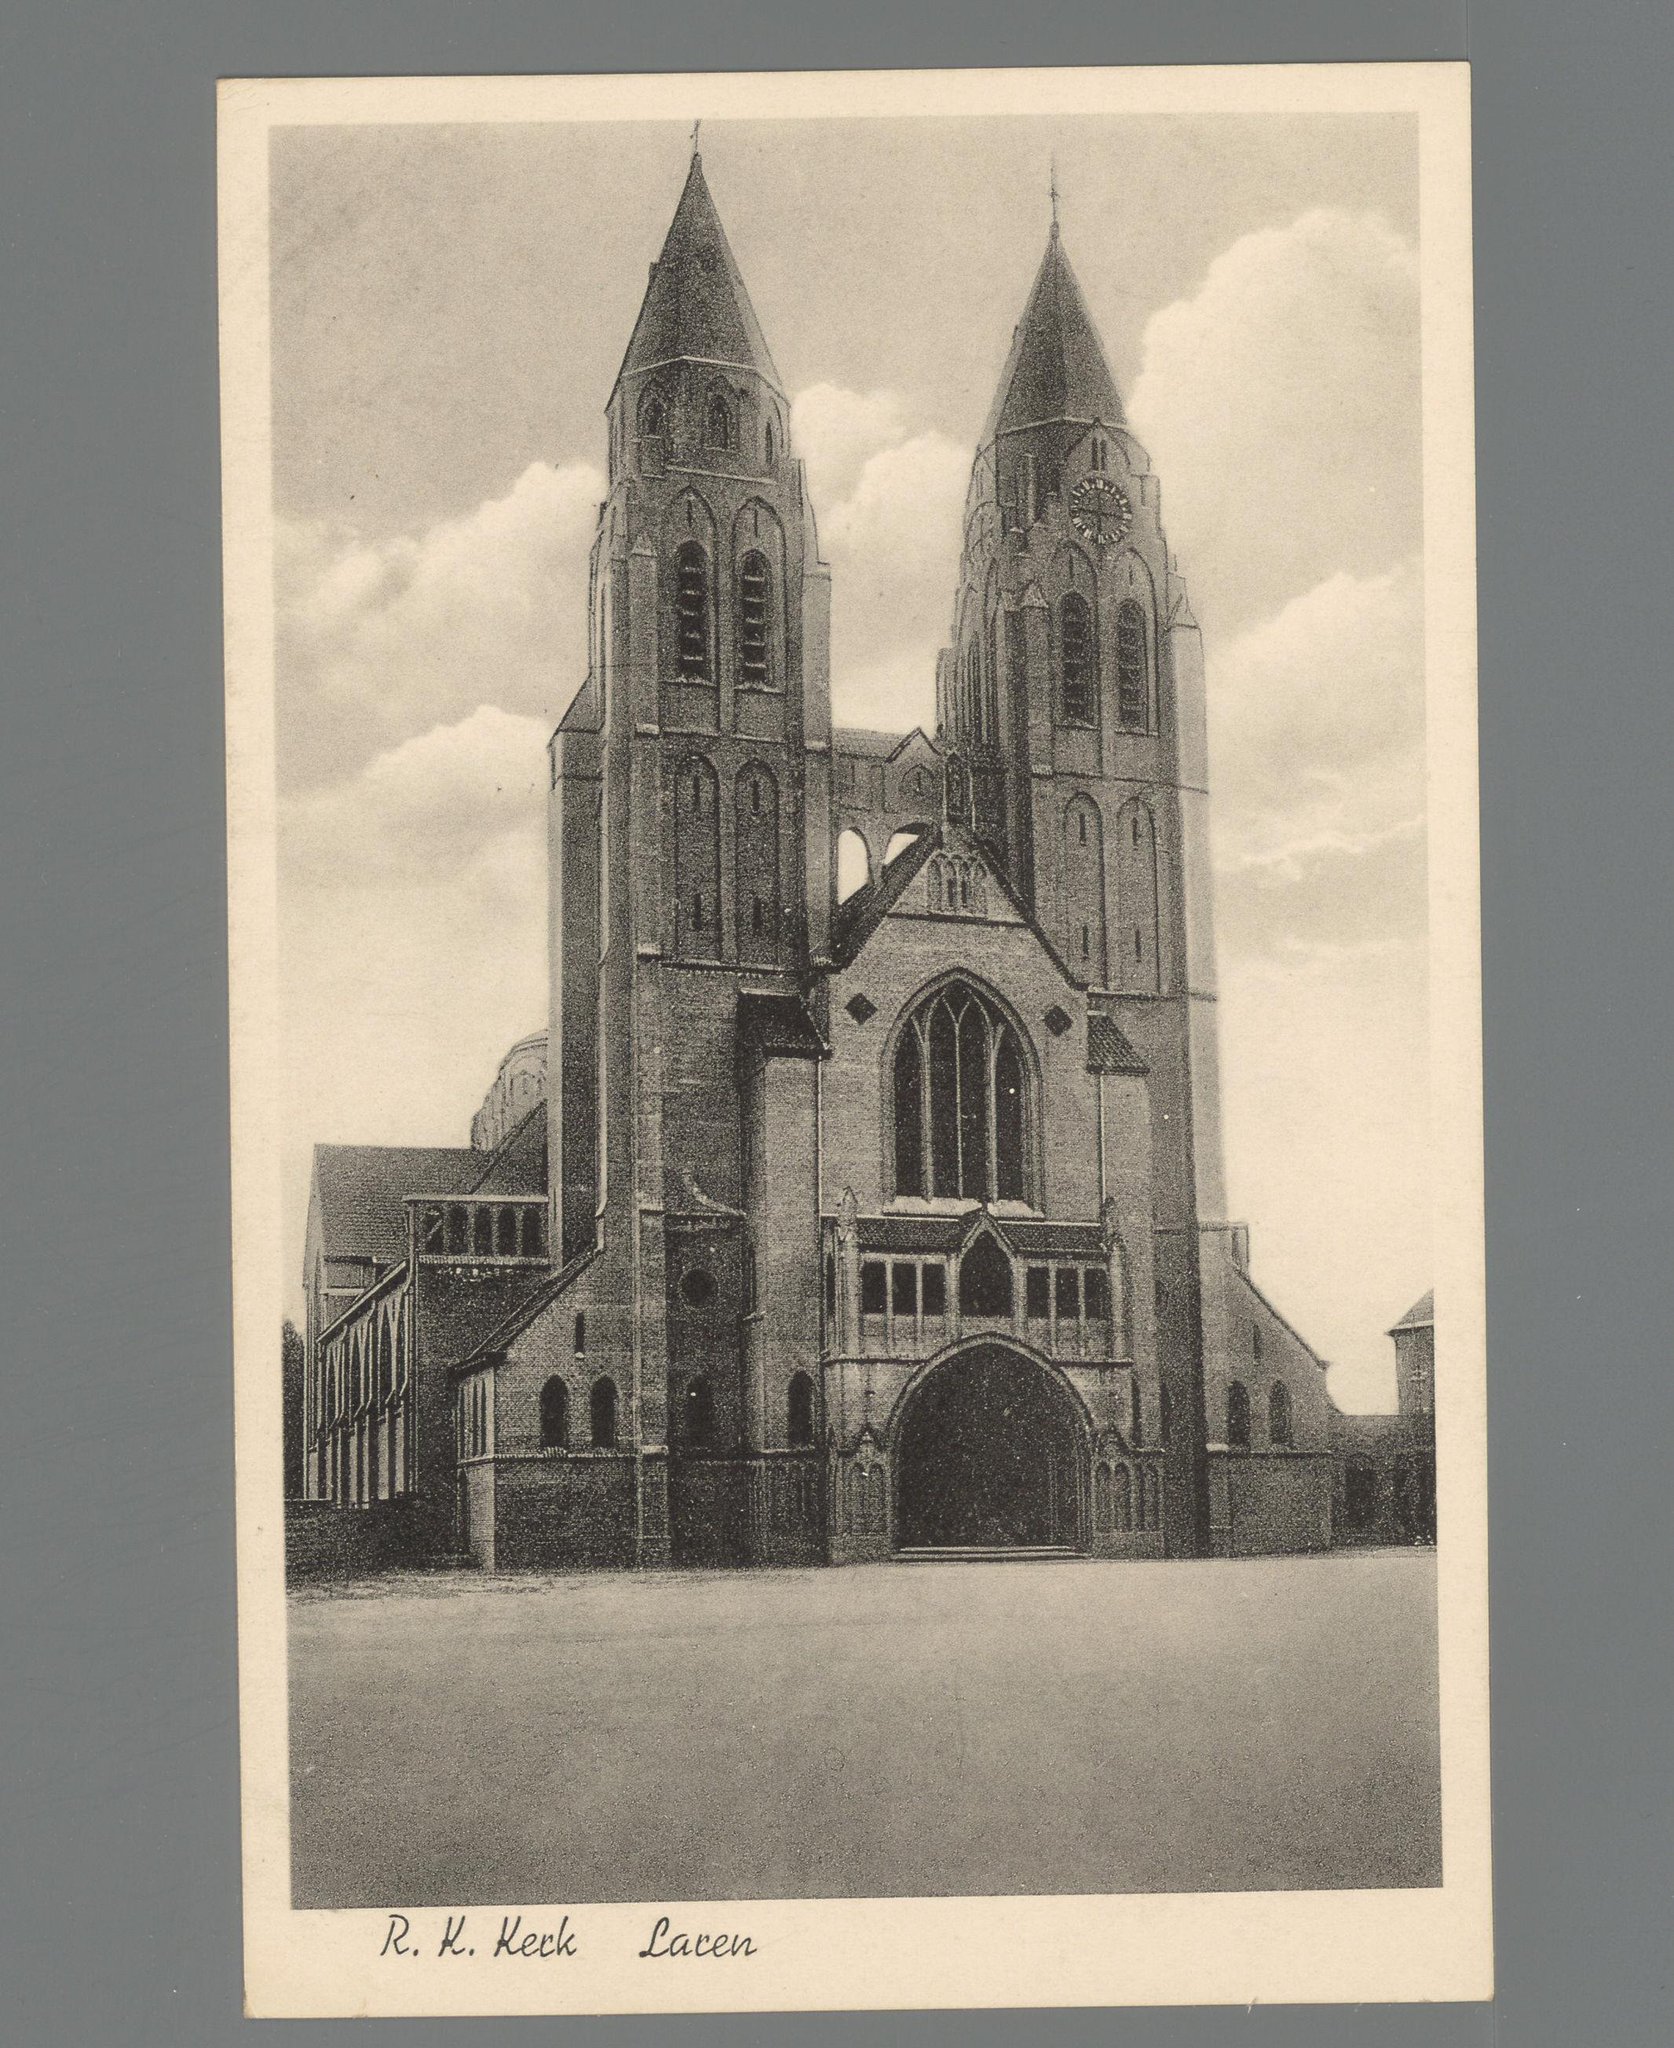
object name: photomechanical print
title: R.K. Kerk. Laren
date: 1936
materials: cardboard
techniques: photograph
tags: church (exterior)